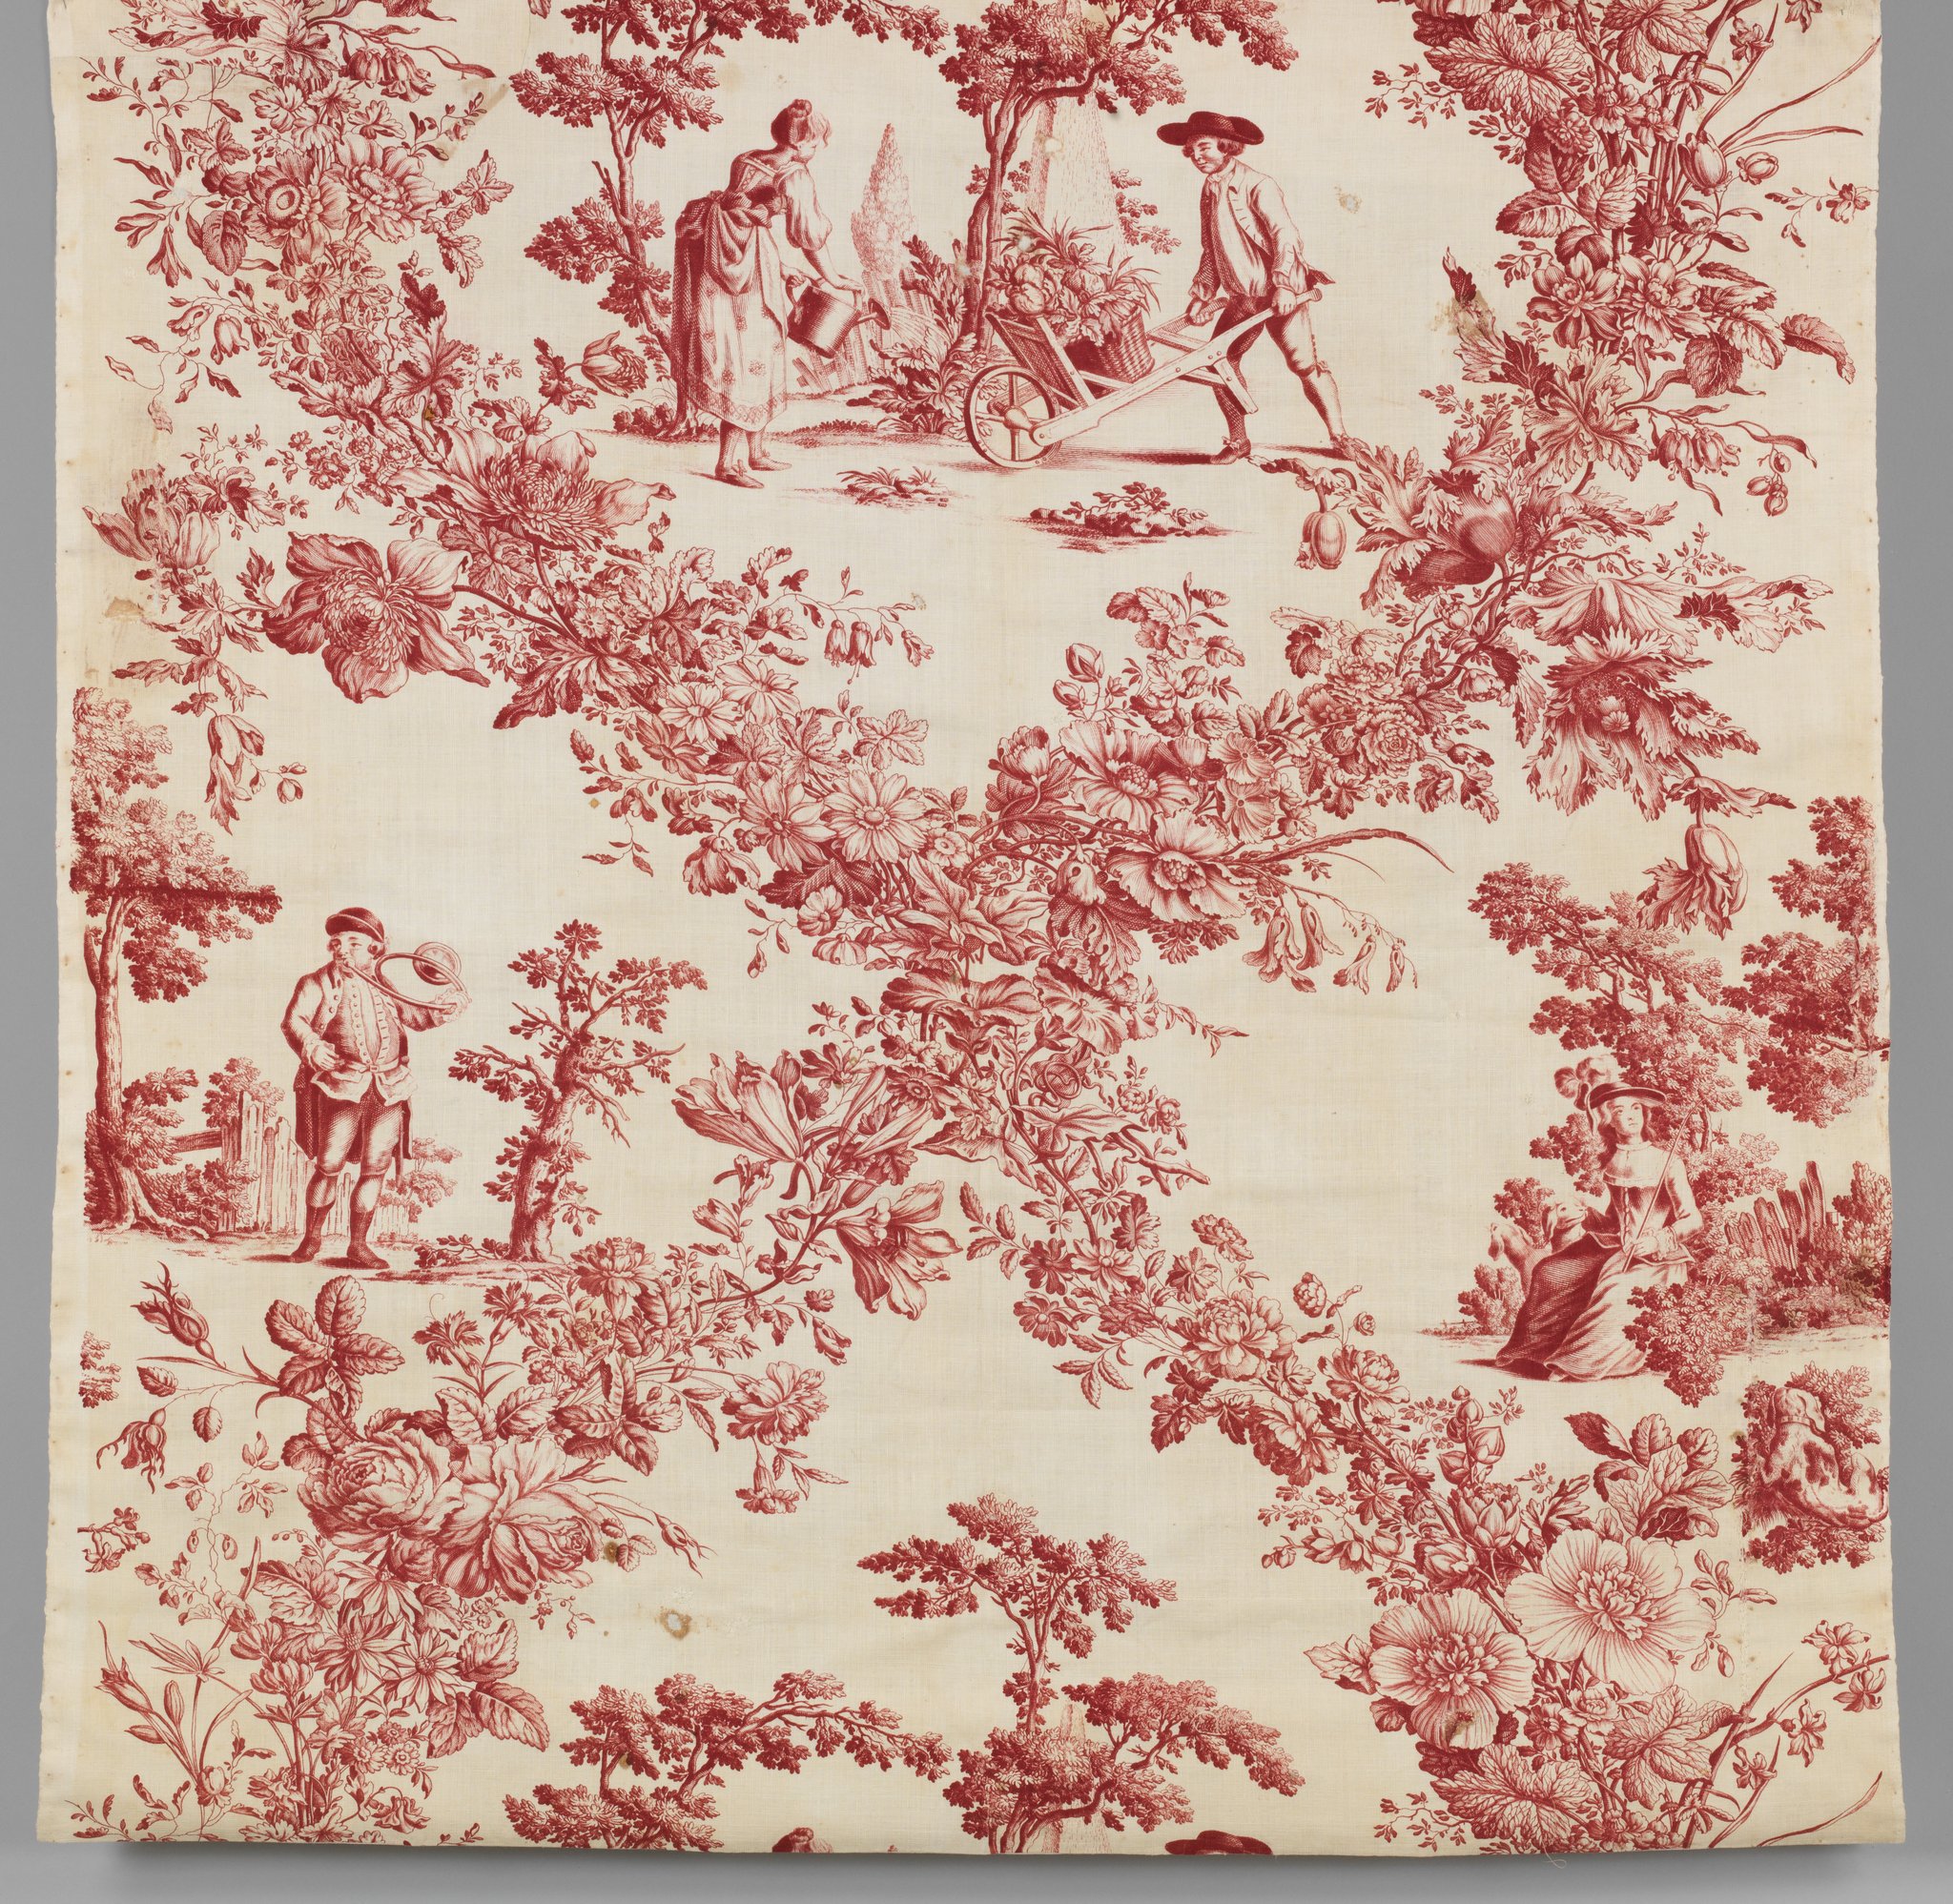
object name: piece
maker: bromley hall printworks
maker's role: manufactory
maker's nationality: english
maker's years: 1694-1823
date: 1775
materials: cotton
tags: men,women,flowers,leaves